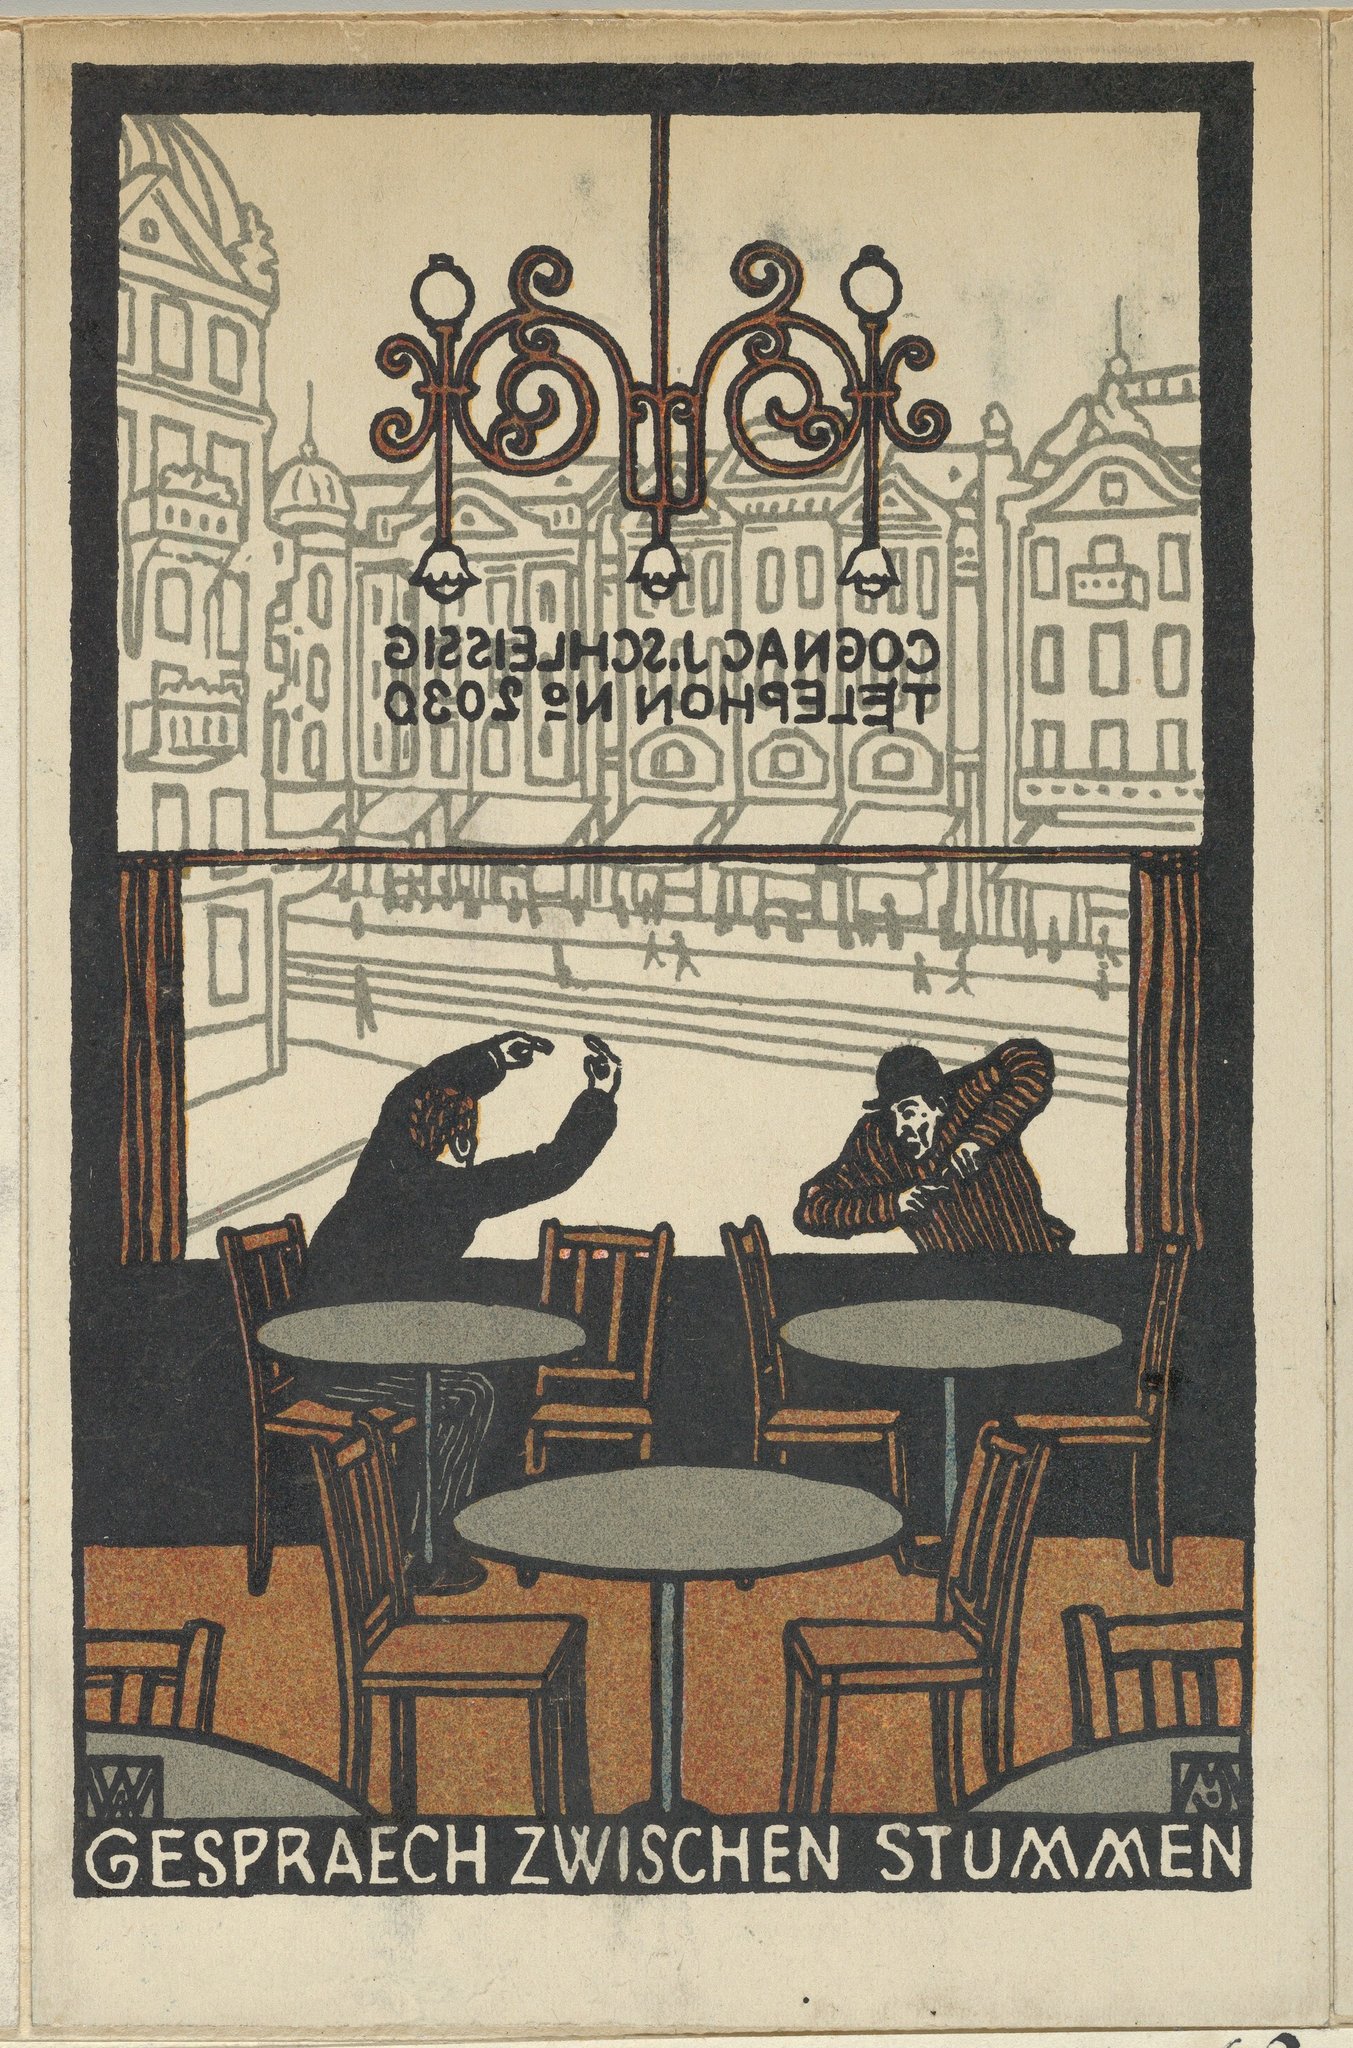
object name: print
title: Conversation between Mutes (Gespraech zwischen Stummen)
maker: moriz jung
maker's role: artist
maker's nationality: austrian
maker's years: 1885-1915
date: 1907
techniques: lithograph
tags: buildings,men,chairs,tables